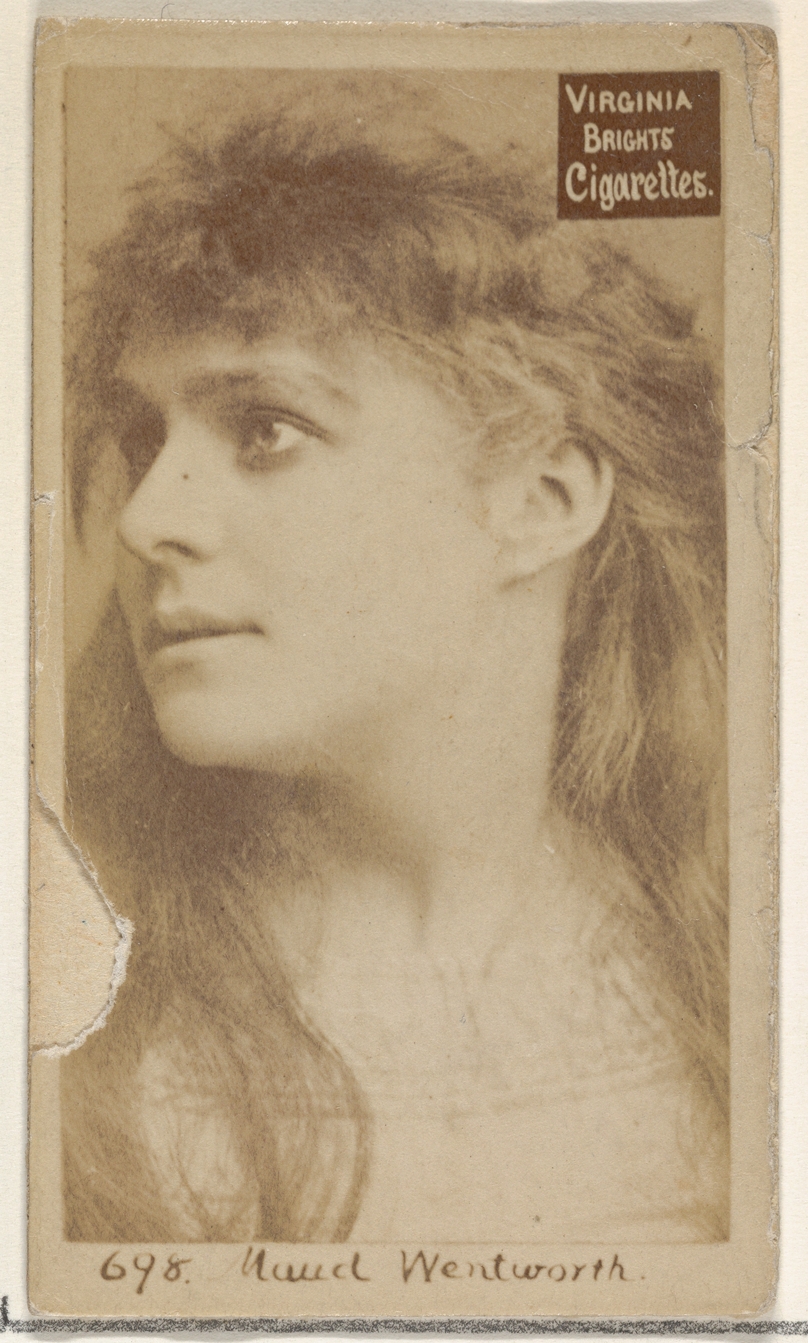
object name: photograph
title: Card 698, Maud Wentworth, from the Actors and Actresses series (N45, Type 2) for Virginia Brights Cigarettes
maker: allen & ginter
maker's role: publisher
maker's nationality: american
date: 1888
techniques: albumen silver print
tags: portraits,profiles,women,actresses